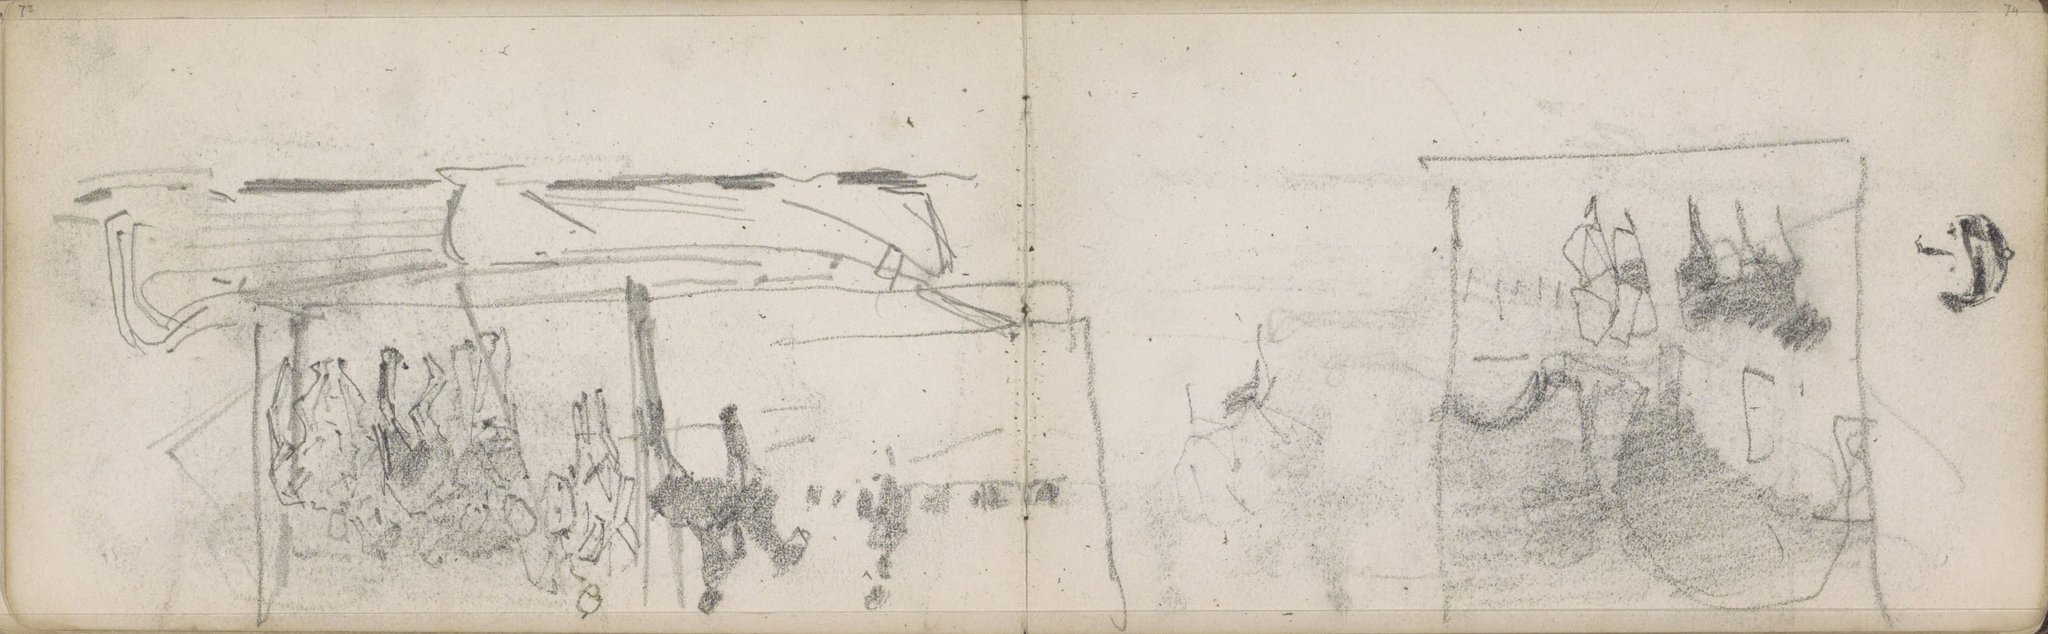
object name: sketchbook leaf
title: Compositiestudies en een boot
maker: george hendrik breitner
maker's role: draughtsman, painter, print maker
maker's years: 1857-1923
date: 1881-1883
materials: paper, pencil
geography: north brabant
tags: riding a horse, ass, or mule; rider, horseman, head (human), rowing-boat, canoe, etc., horse, the soldier; the soldier's life (+ cavalry, horsemen)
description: Compositiestudie met cavaleristen, compositiestudie met paarden, een mannenhoofd en een boot. Pagina 73 en pagina 74 uit een schetsboek met 42 bladen.